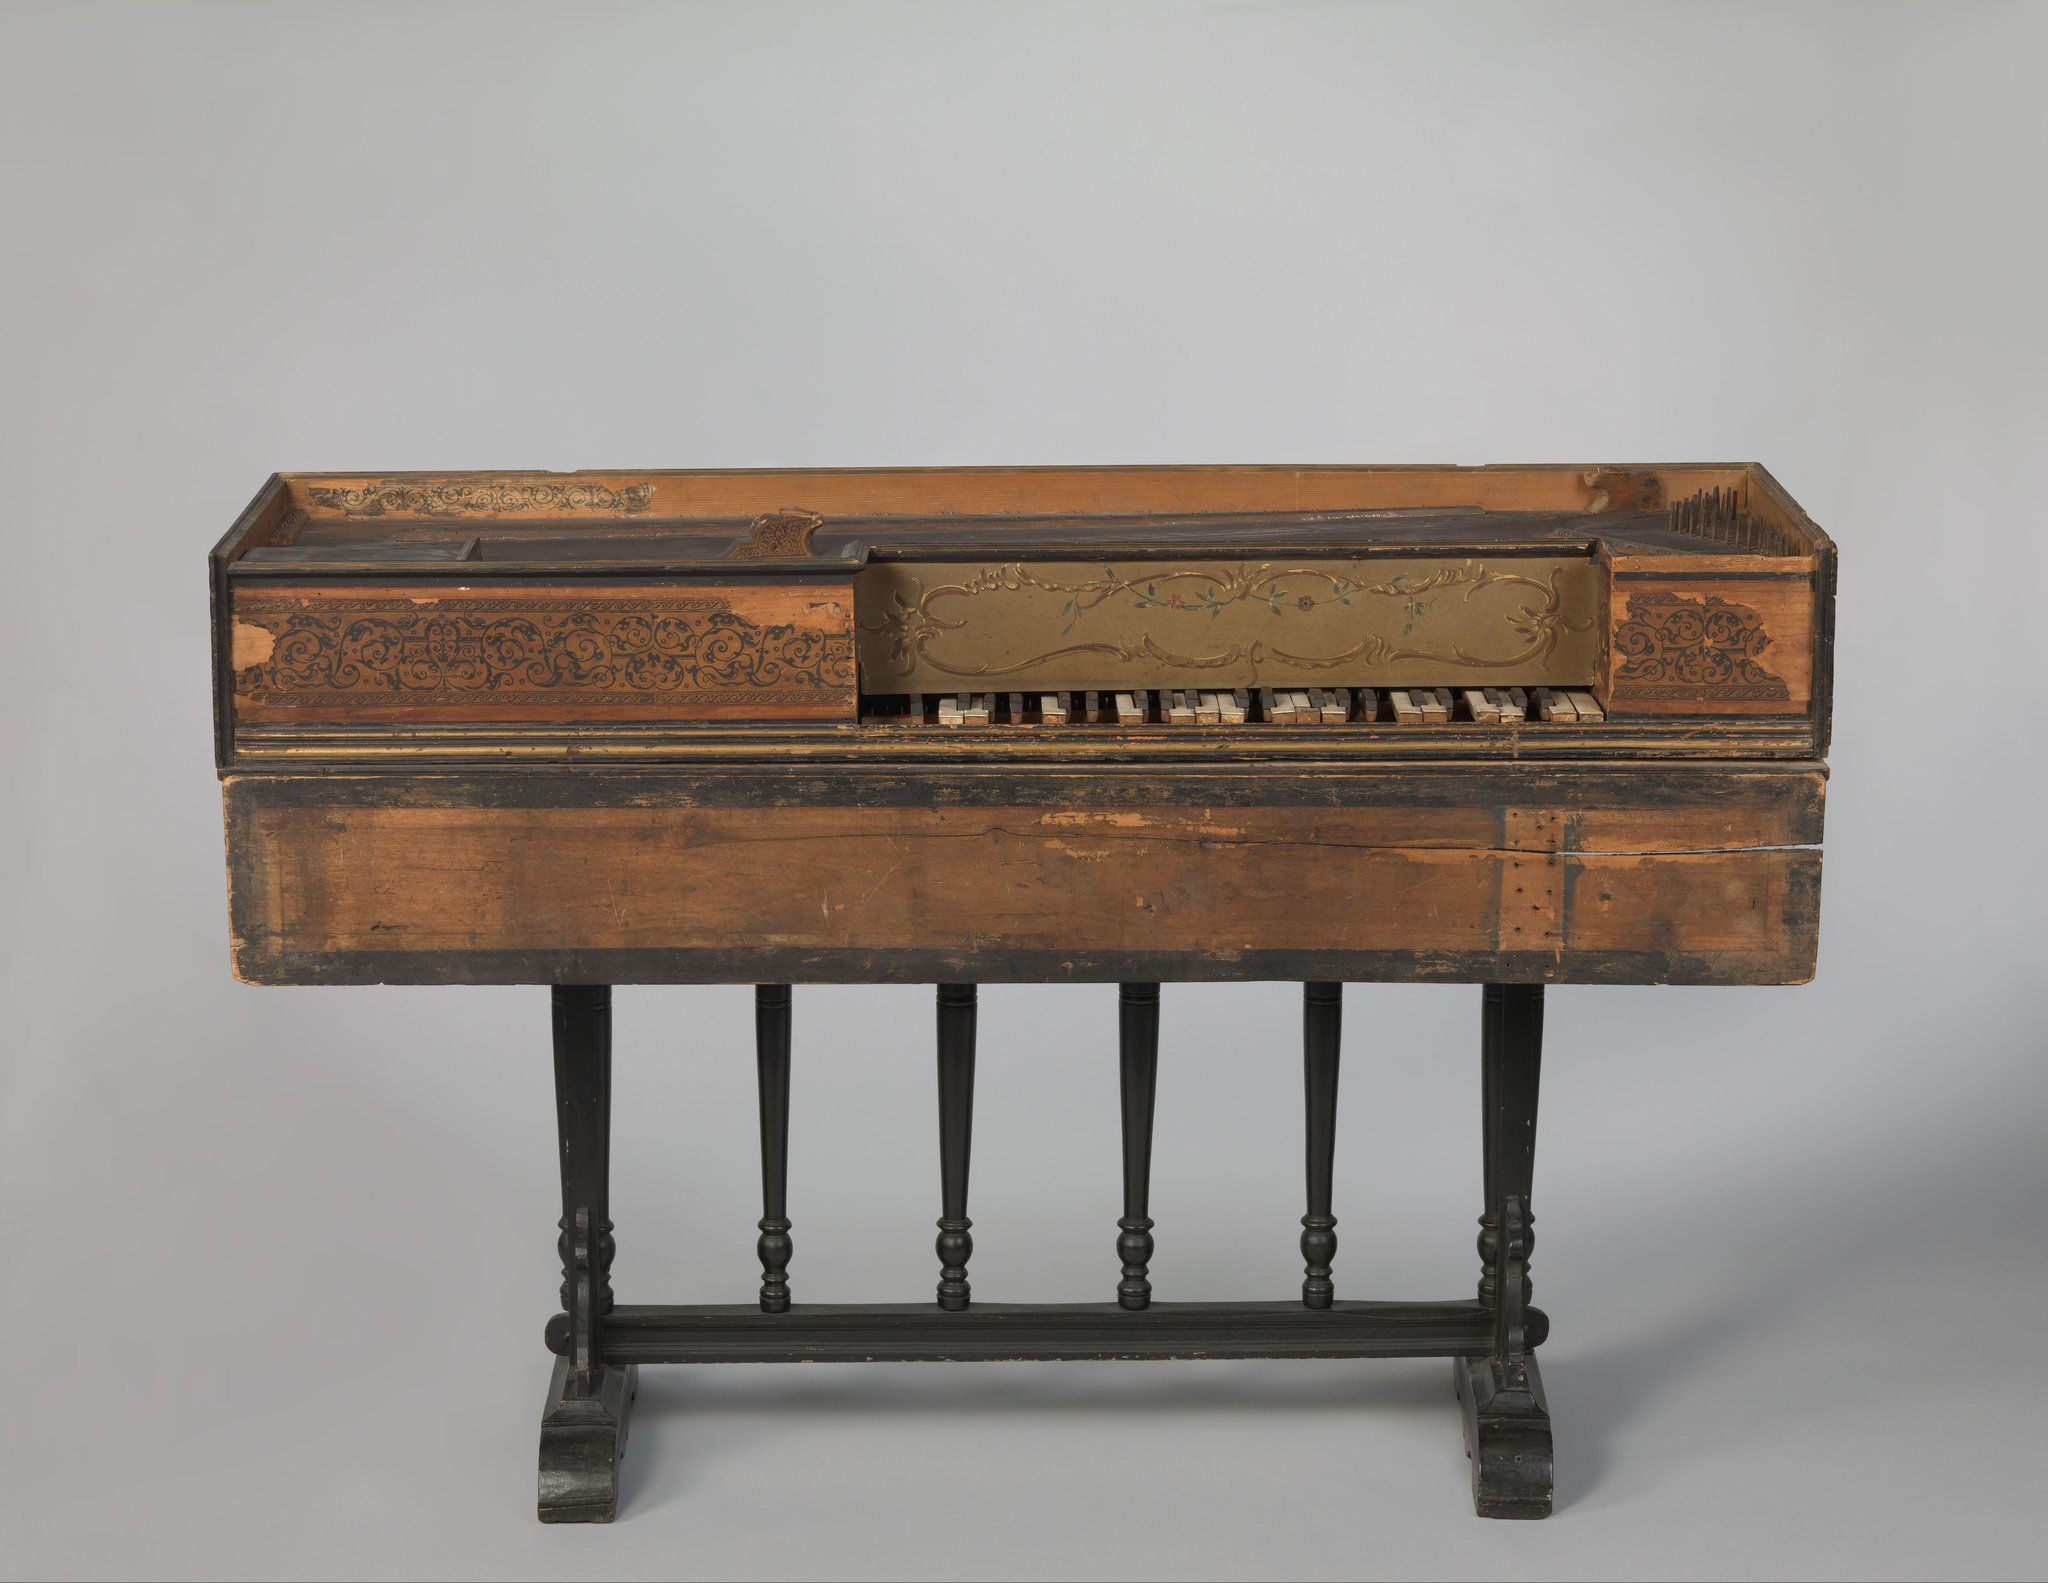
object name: musical instrument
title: Virginal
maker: andreas ruckers (i)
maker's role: musical instrument maker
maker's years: 1579-1652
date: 1643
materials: wood